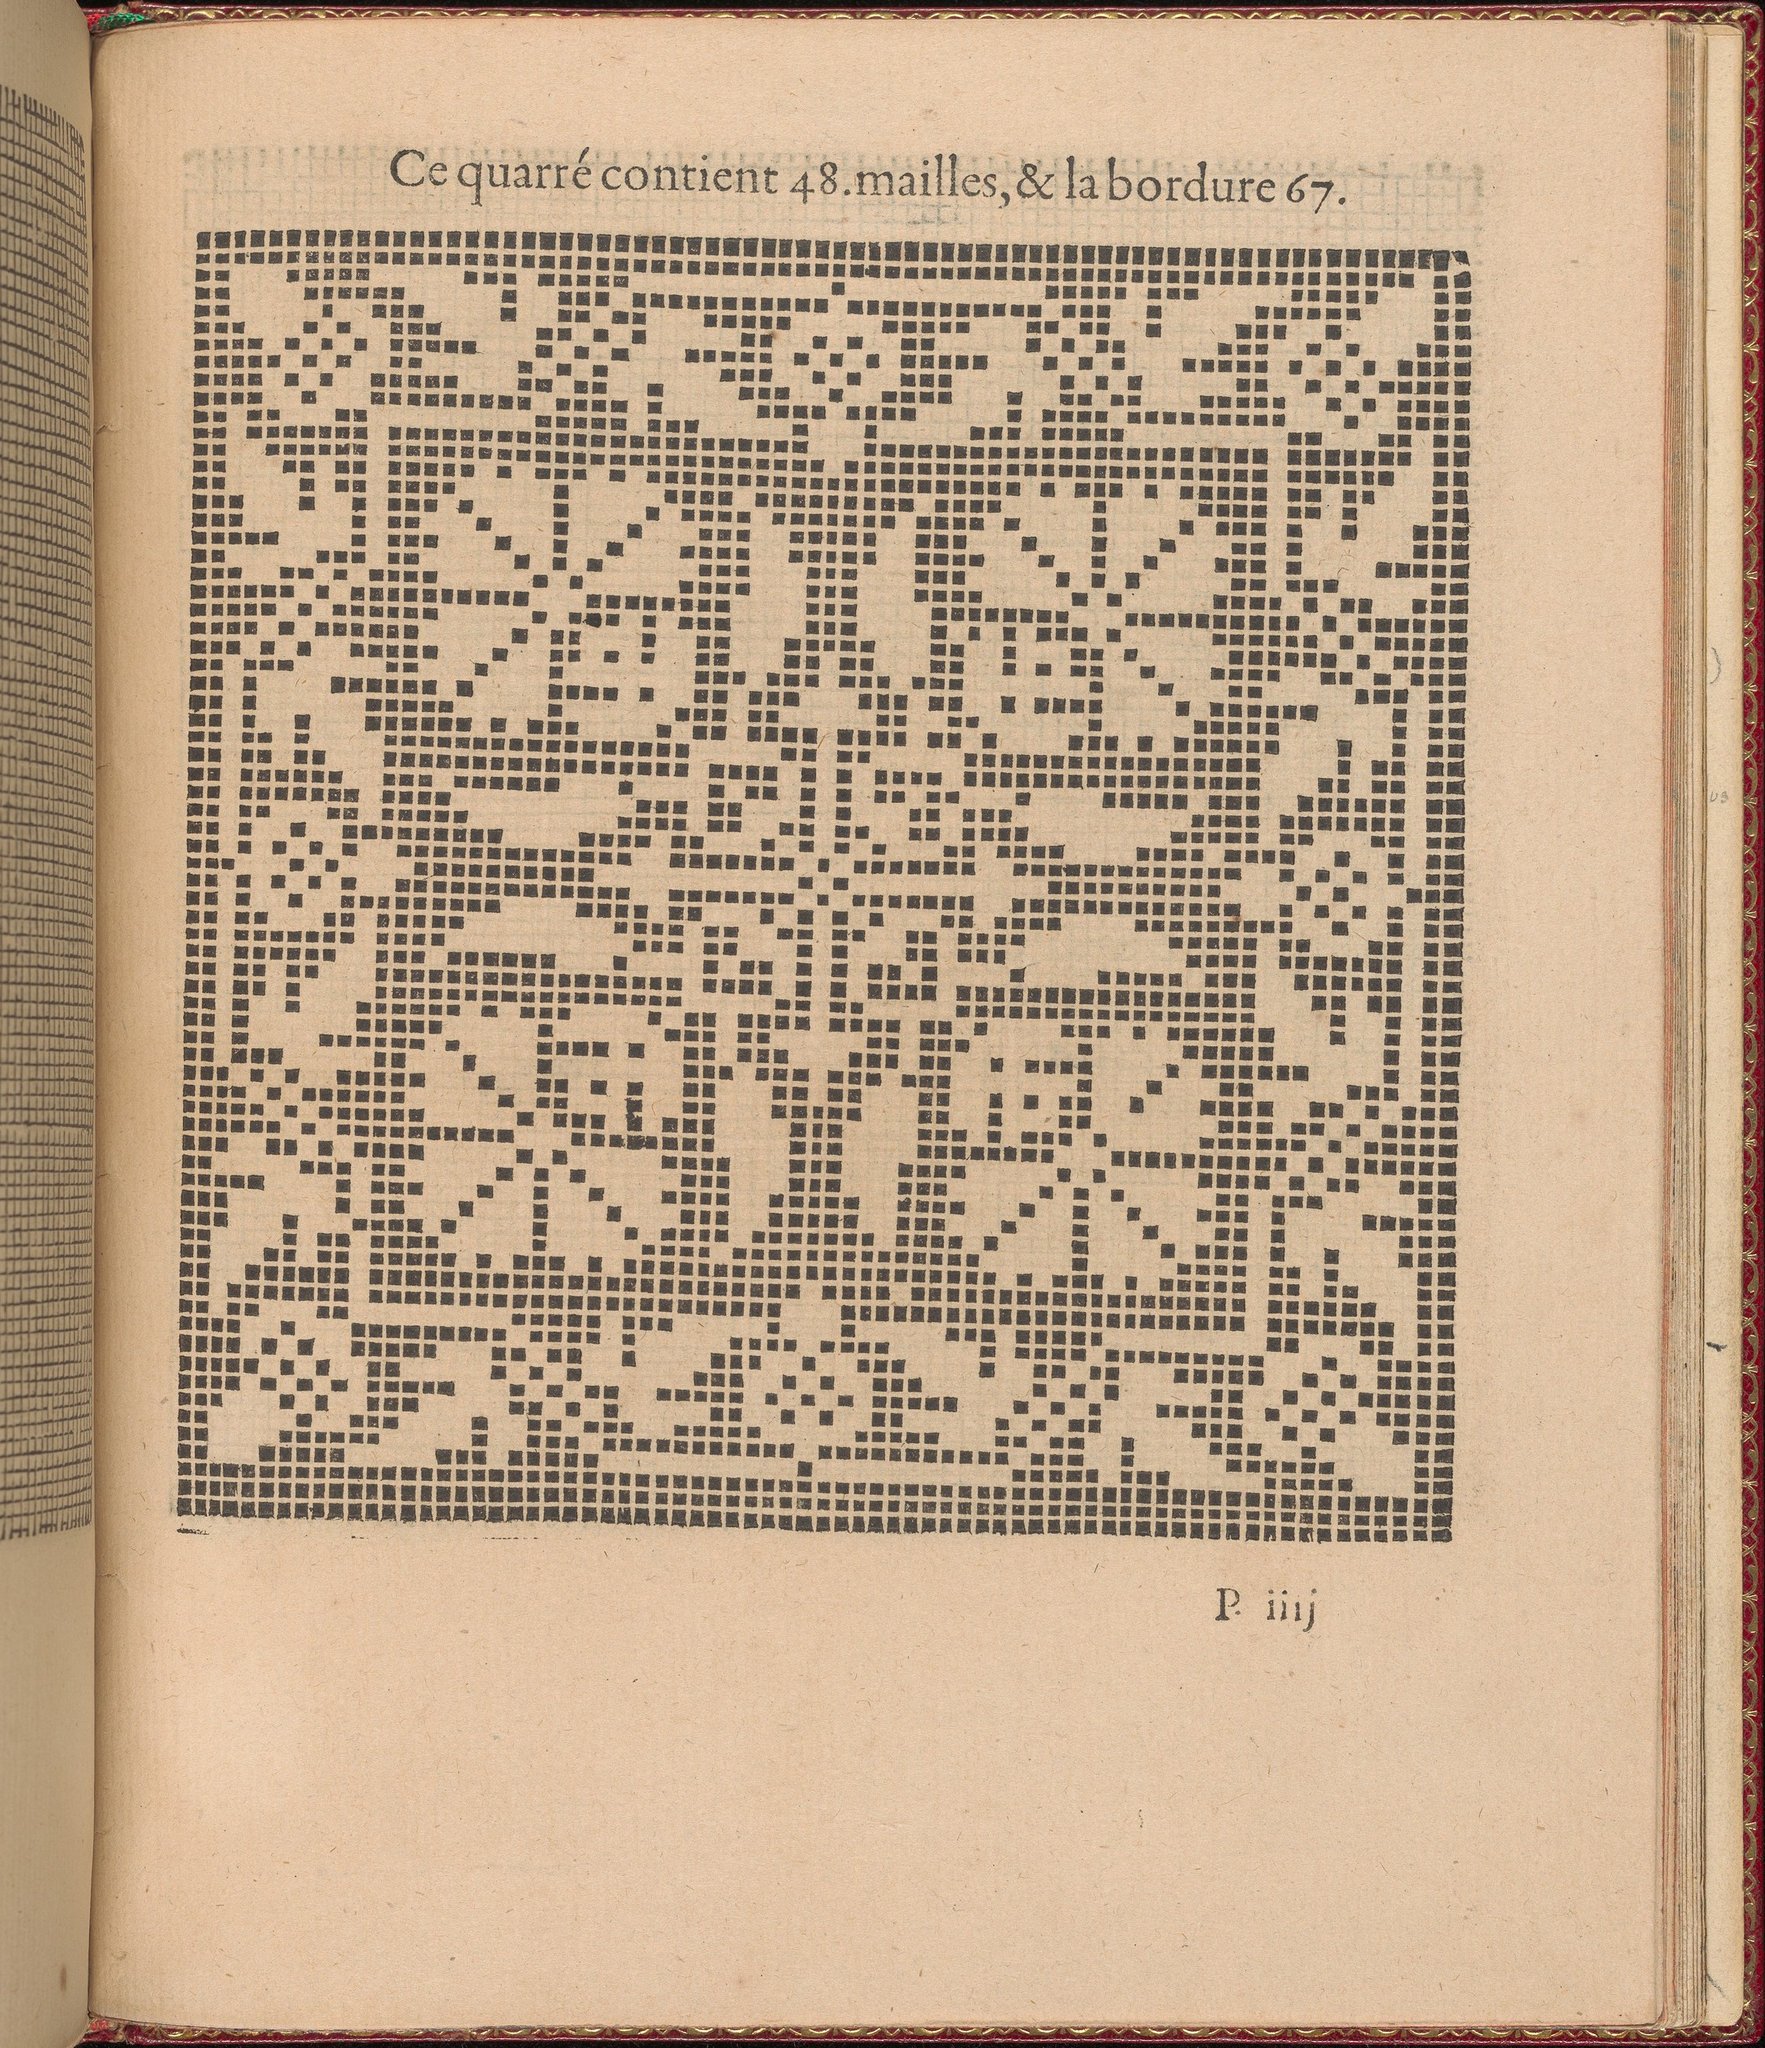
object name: book print ornament architecture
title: Les Singuliers et Nouveaux Portraicts... page 60 (recto)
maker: federico de vinciolo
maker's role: designer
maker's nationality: italian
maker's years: 1582-1599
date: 1588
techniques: woodcut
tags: flowers